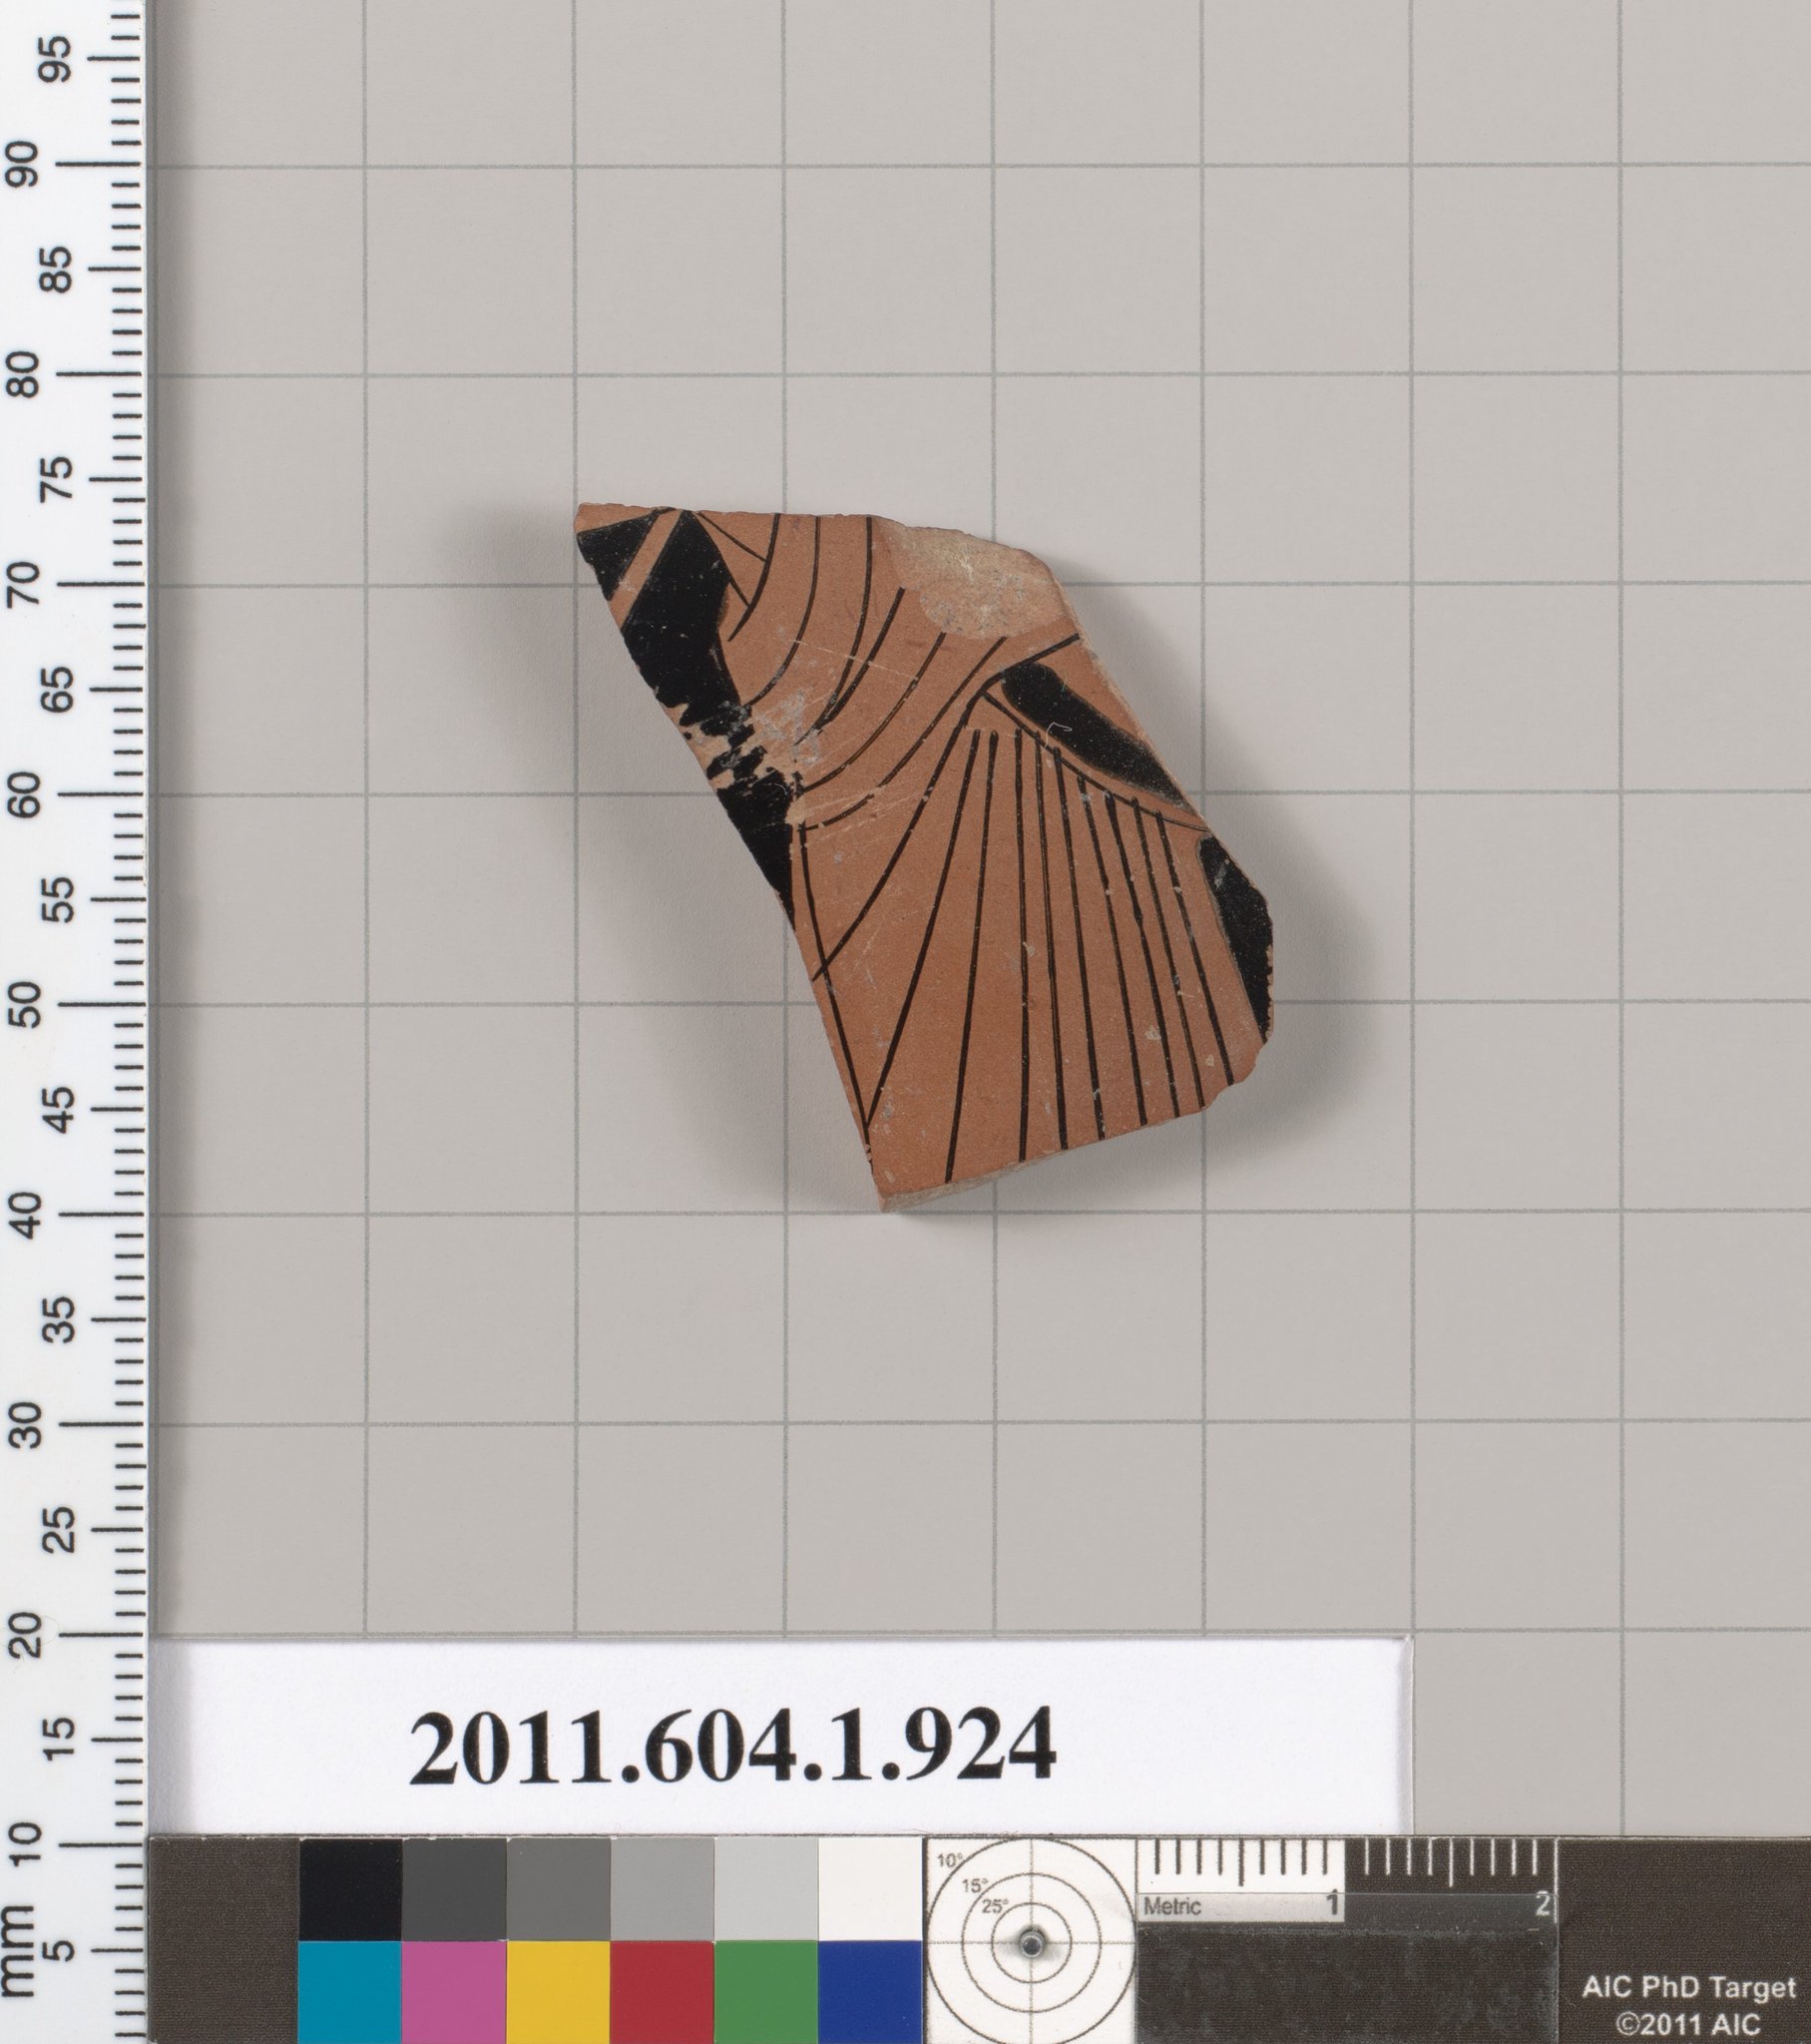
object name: kylix fragment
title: Terracotta fragment of a kylix (drinking cup)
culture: greek, attic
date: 490-480 BCE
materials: terracotta